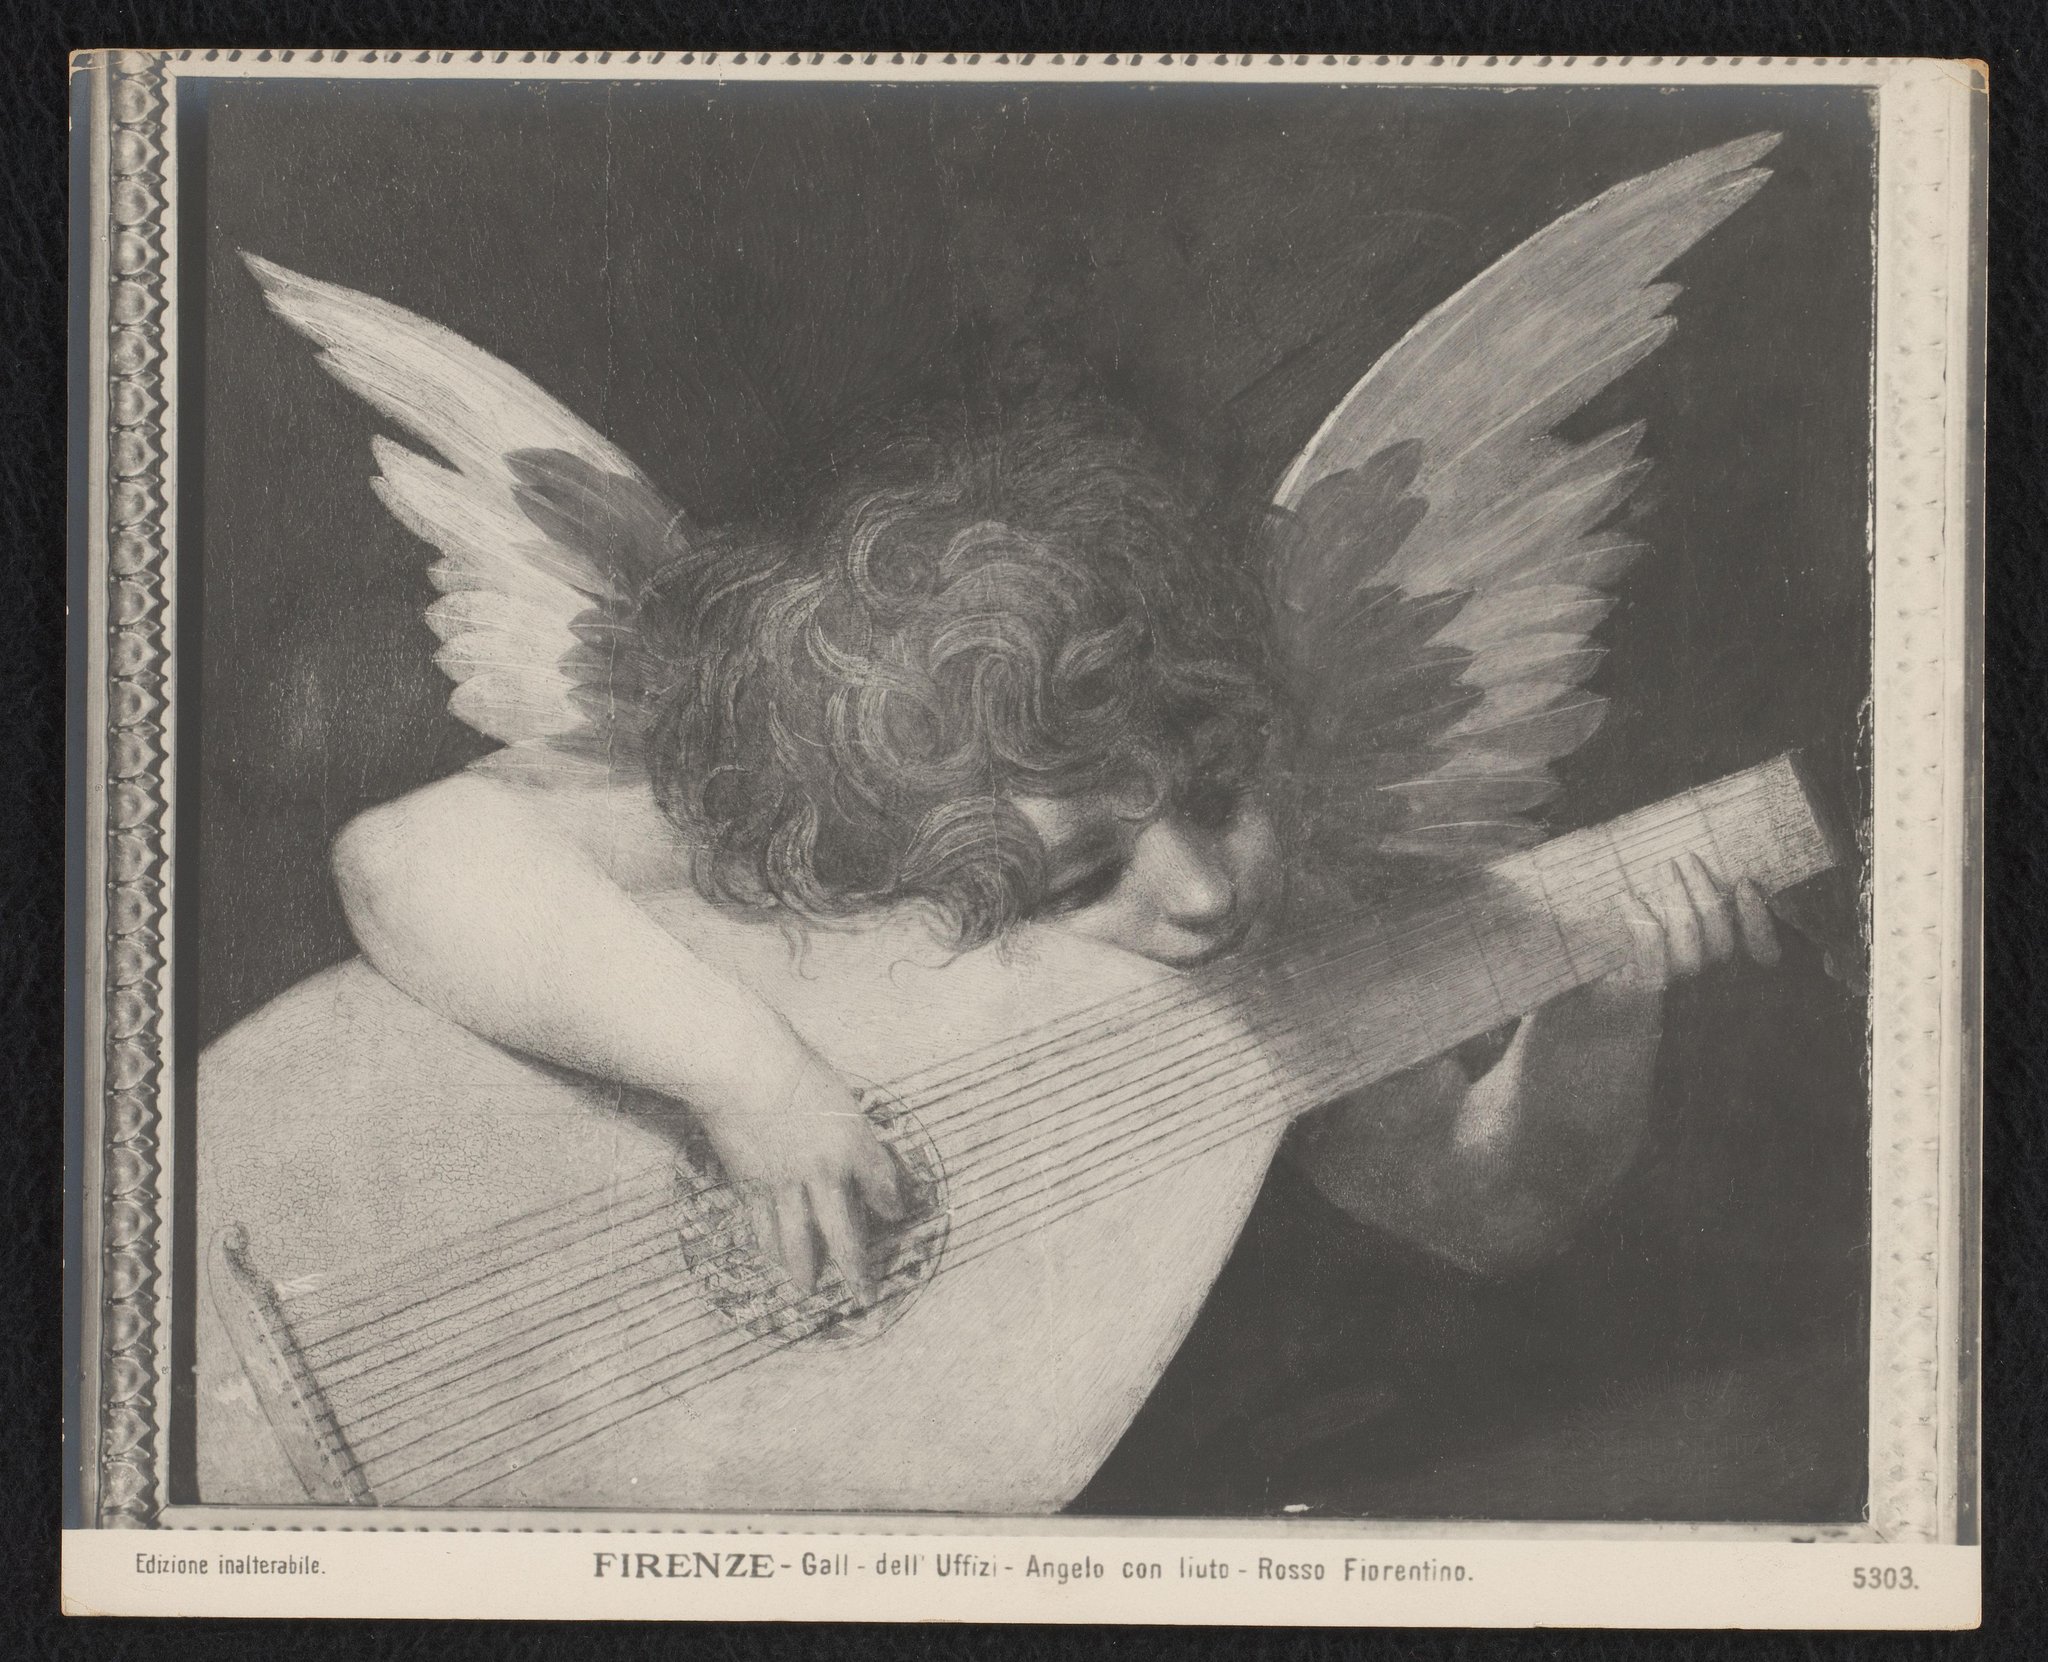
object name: photograph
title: Gall - dell'Uffizi - Angelo con liuto - Rosso Fiorentino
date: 1901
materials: paper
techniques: gelatin silver print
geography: florence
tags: picture, painting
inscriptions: number: ‘5303.’, collector's mark: ‘RIJKS SCHOOL VOOR KUNSTNIJVERHEID/ GROEP’, inscription: ‘Edizione inalterabile.’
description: Deze foto maakt deel uit van een omslag.